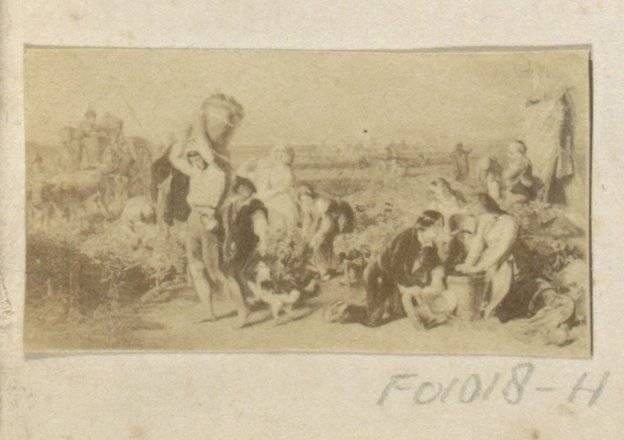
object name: reproduction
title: Fotoreproductie van (vermoedelijk) een schilderij met een oogsttafereel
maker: Anonymous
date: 1860-1870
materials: paper, photographic support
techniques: albumen print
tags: harvest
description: Onderdeel van Engels familiealbum met foto's van personen, reizen, cricket en kunstwerken.